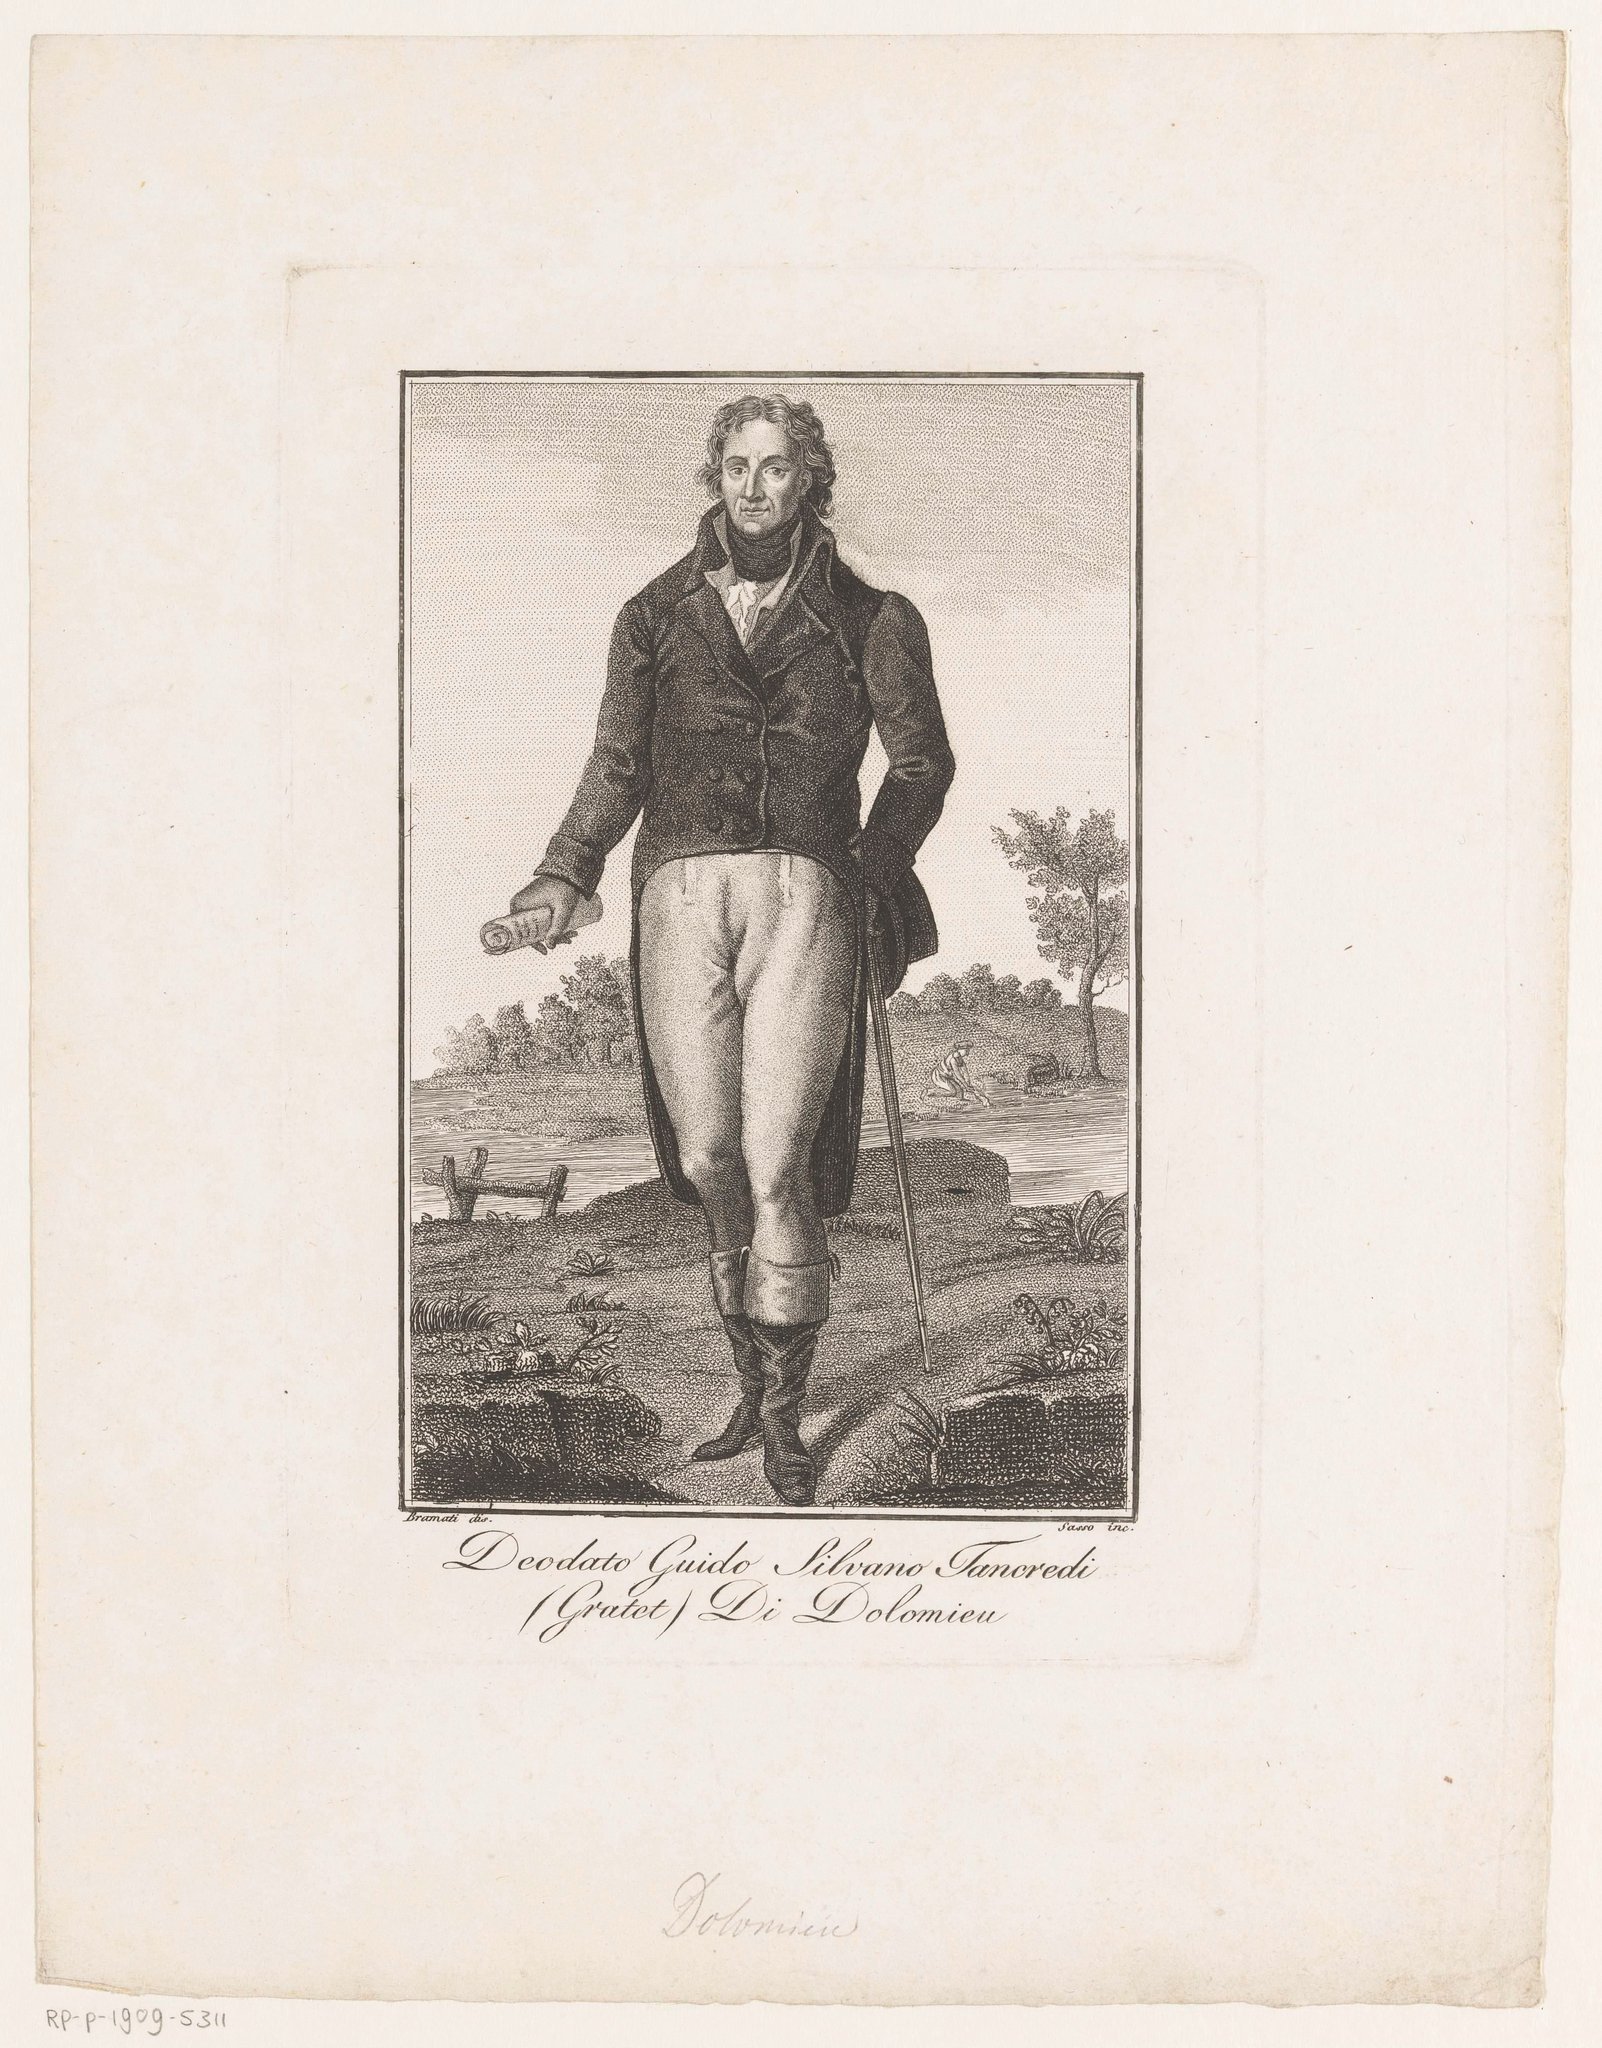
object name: print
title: Portret van geoloog Déodat Gratet de Dolomieu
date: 1809-1816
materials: paper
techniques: engraving, etching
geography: italy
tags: historical persons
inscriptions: collector's mark: Lugt 2228